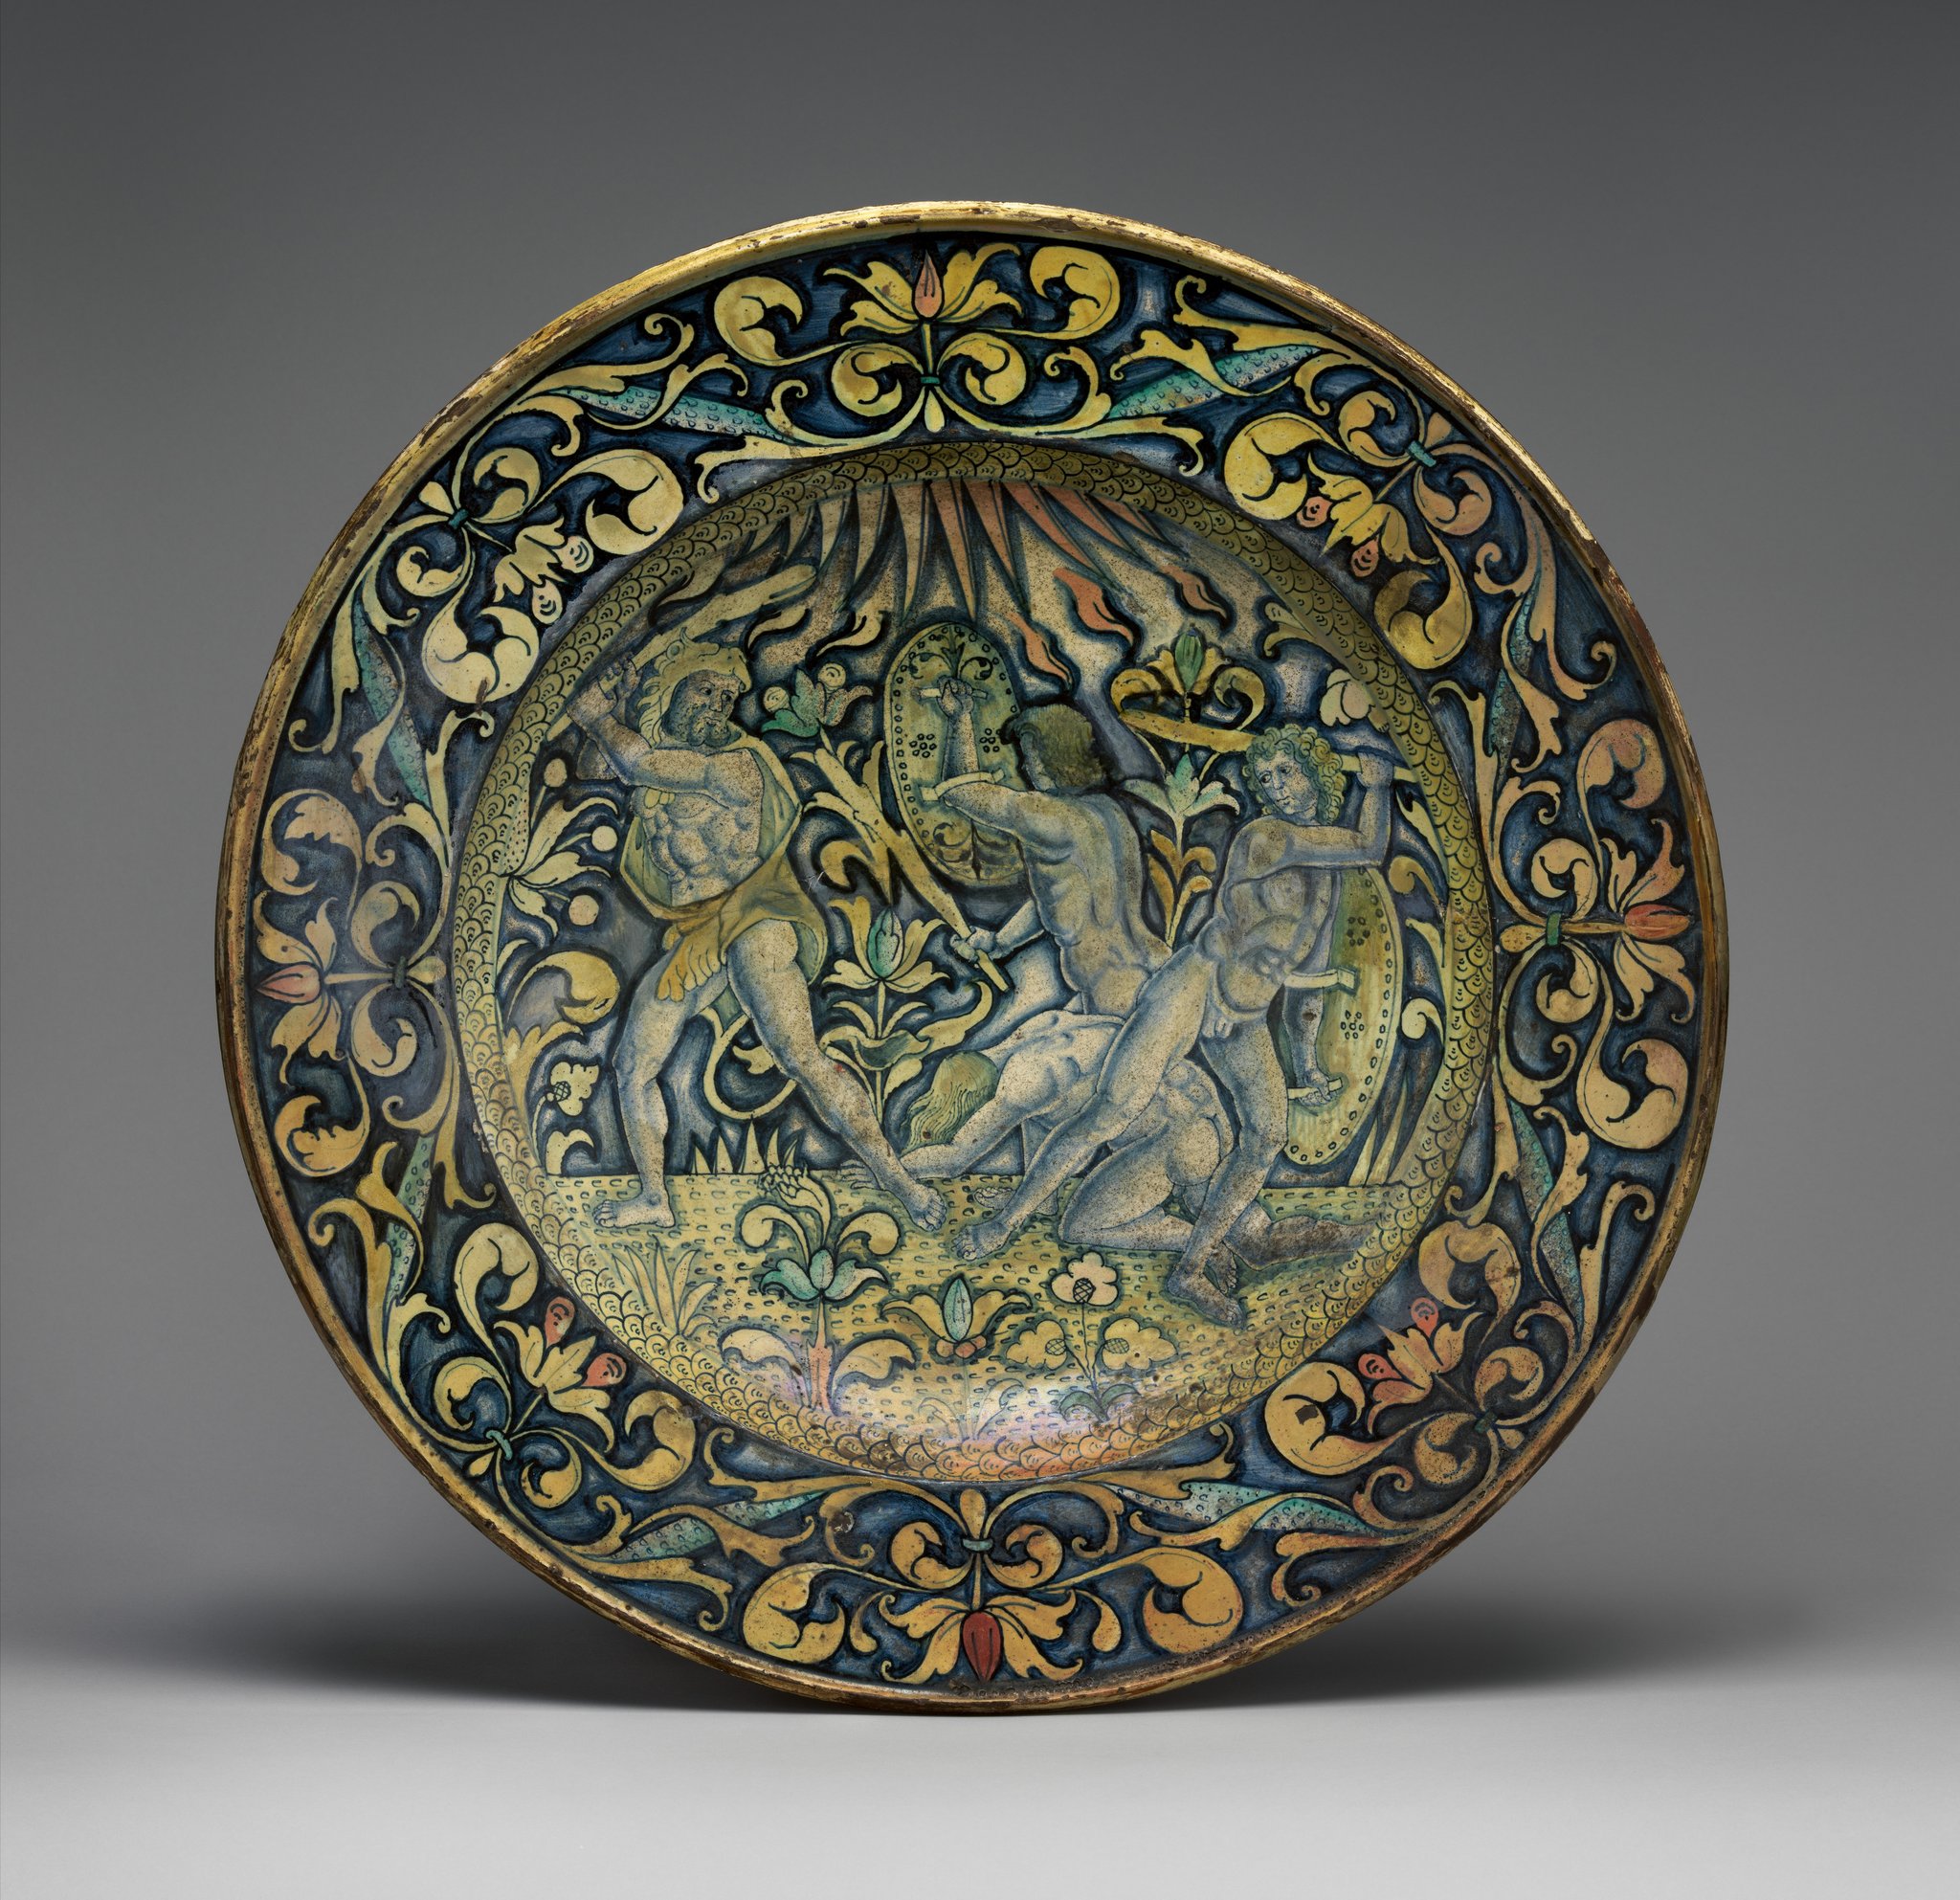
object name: dish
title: Dish (piatto); The story of Hercules: the gods called upon Hercules to help them defend Olympus against the attack of the Giants, sons of Uranus and Gaea (Heaven and Earth)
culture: italian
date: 1510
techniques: maiolica, glazing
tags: male nudes,hercules